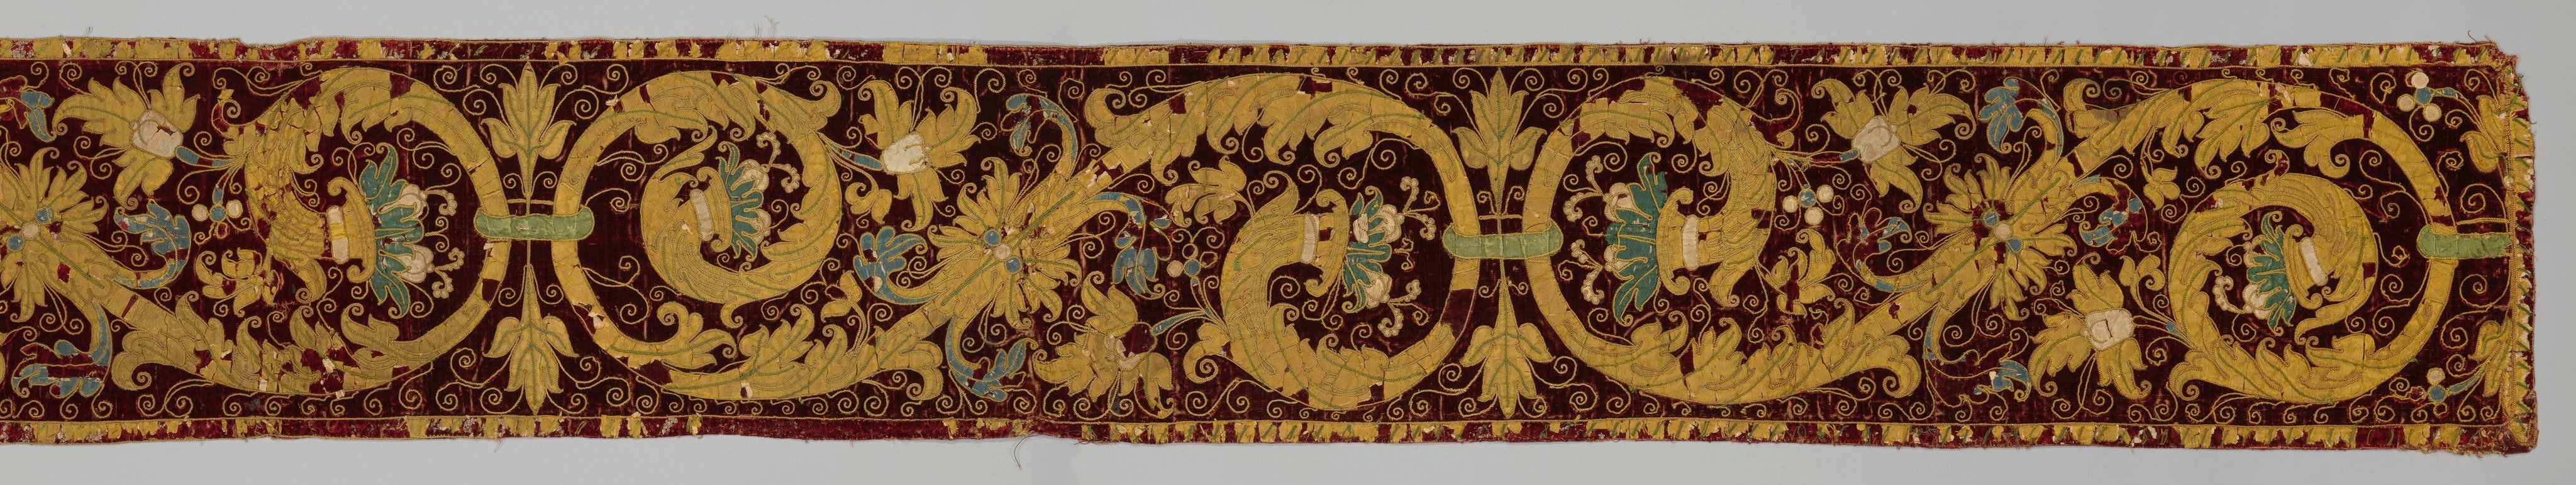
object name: lambrequin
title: Lambrekijn of strook van applicatie borduurwerk; satijn en koordzijde op fluweel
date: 1550-1600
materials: textile, silk, velvet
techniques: embroidered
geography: italy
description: Lambrekijn of strook van applicatie-borduurwerk; satijn en koordzijde op fluweel. Op een wijnrood fond heeft het patroon gele, liggende S-ranken binnen een omlijsting van geel. Zijden damast is gebruikt voor de knooppunten, voor het hart van een palmetbloem, voor acanthusbladeren en voor de voluut beeindiging. De contouren en enkele hechtranken zijn van koordzijde in geel en groen. Bij de strook of lambrekijn hoort een tweede strook of lambrekijn.